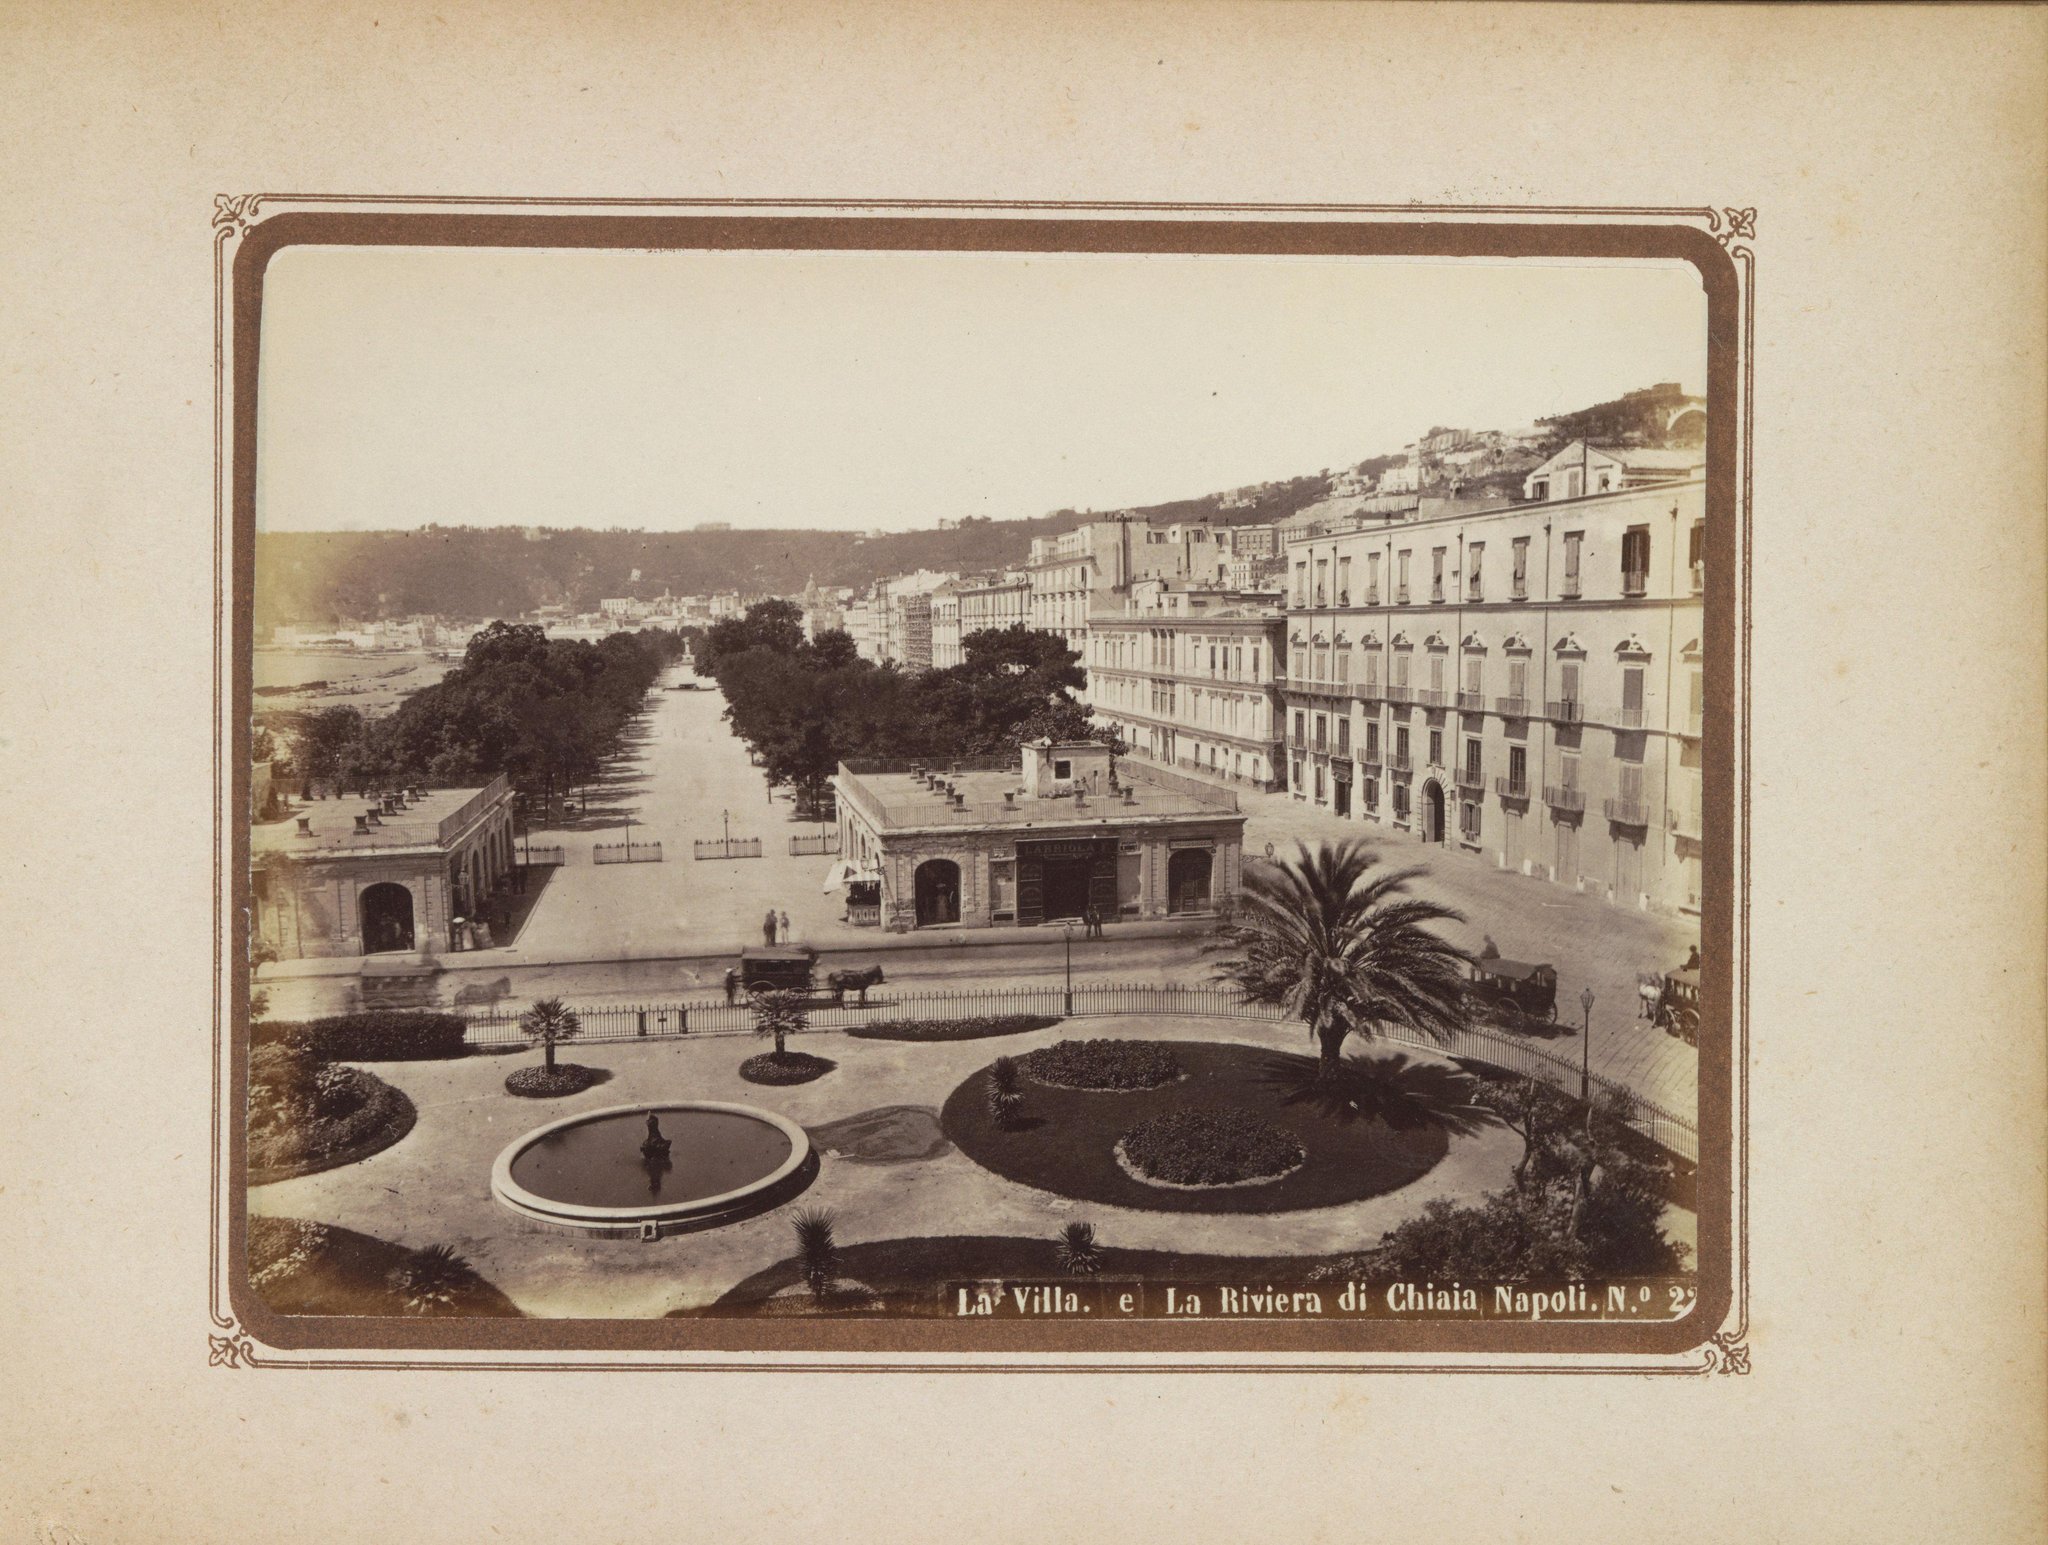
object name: photograph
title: Gezicht op de ingang van de Villa en de Riviera di Chiaia in Napels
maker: roberto rive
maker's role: fotograaf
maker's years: 1825-1868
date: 1860-1900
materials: paper, photographic support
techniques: albumen print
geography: naples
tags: public gardens, park, naples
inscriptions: number: ‘2[...]’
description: Onderdeel van Fotoalbum met bezienswaardigheden in Napels en omgeving door Roberto Rive.